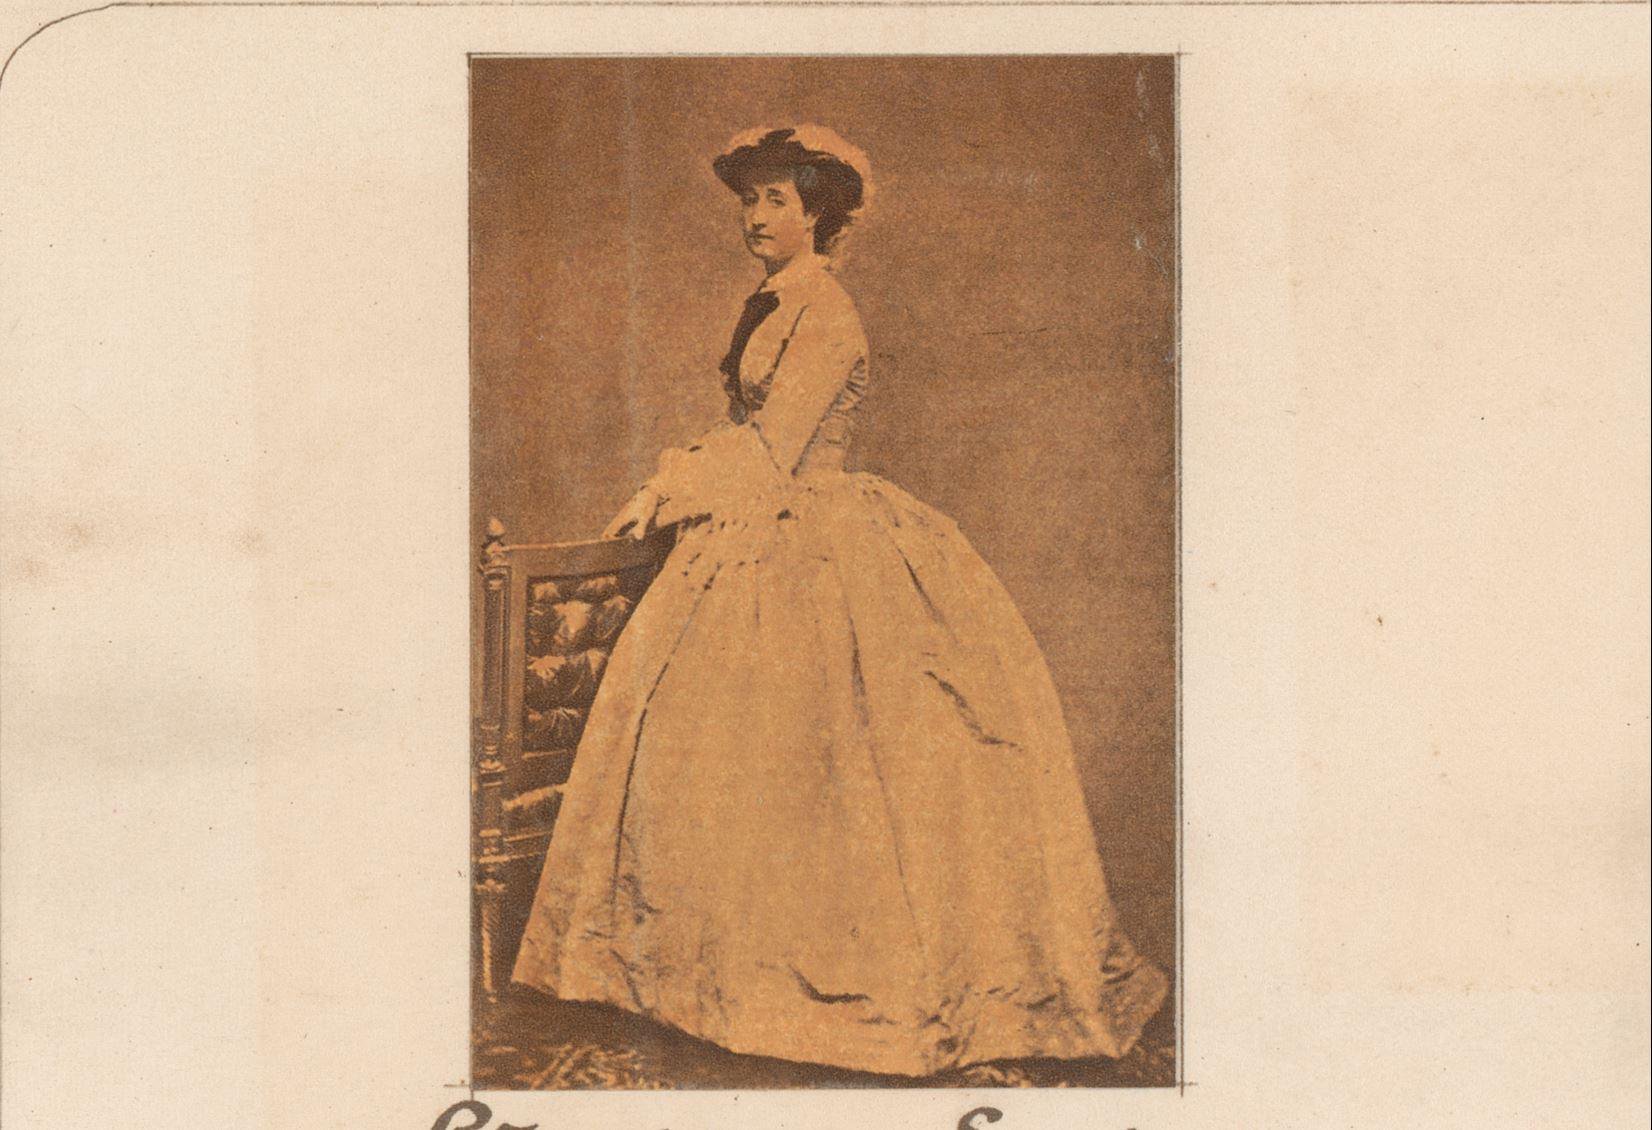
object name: photomechanical print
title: L'Impératrice Eugénie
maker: Anonymous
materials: paper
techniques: rotogravure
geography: france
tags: sevilla, queen, empress, etc. (wife of a ruler), historical persons, france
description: Deze prent maakt deel uit van een album.